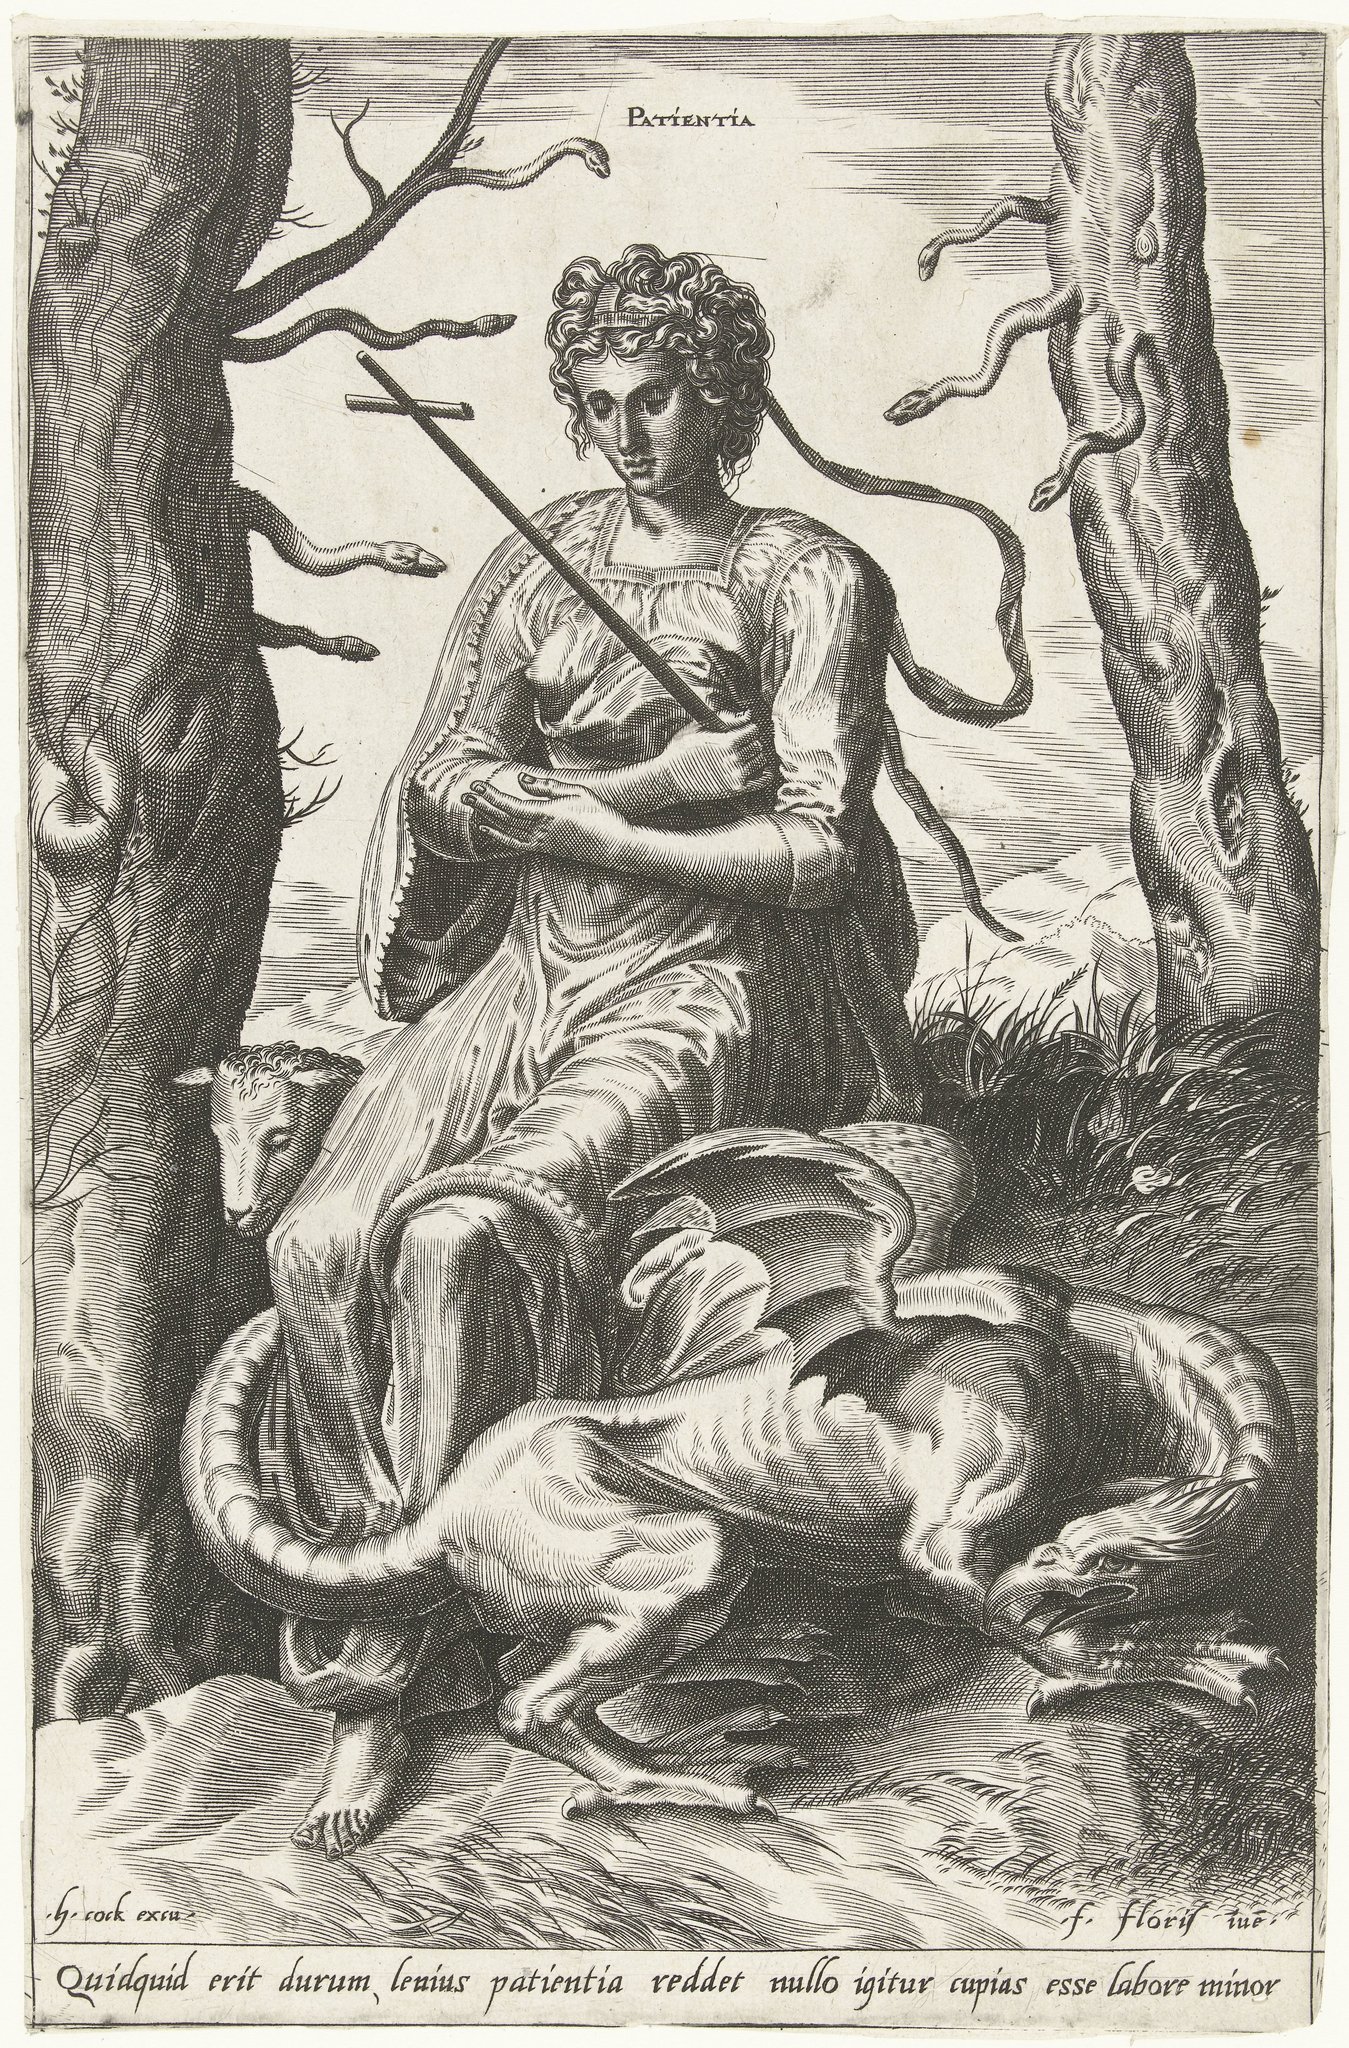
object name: print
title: Deugden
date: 1560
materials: paper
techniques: engraving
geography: antwerp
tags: patience; 'patienza' (ripa)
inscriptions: collector's mark: Lugt 2760, collector's mark: Lugt 2228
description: De personificatie van de Geduld zit tussen twee bomen op de grond, een draak aan haar voeten. Ze houdt haar armen voor de borst gekruist en draagt een kruis onder haar arm. Uit de bomen groeien slangen, symbolen voor de verzoeking die Geduld probeert te weerstaan. Naast haar een lam.